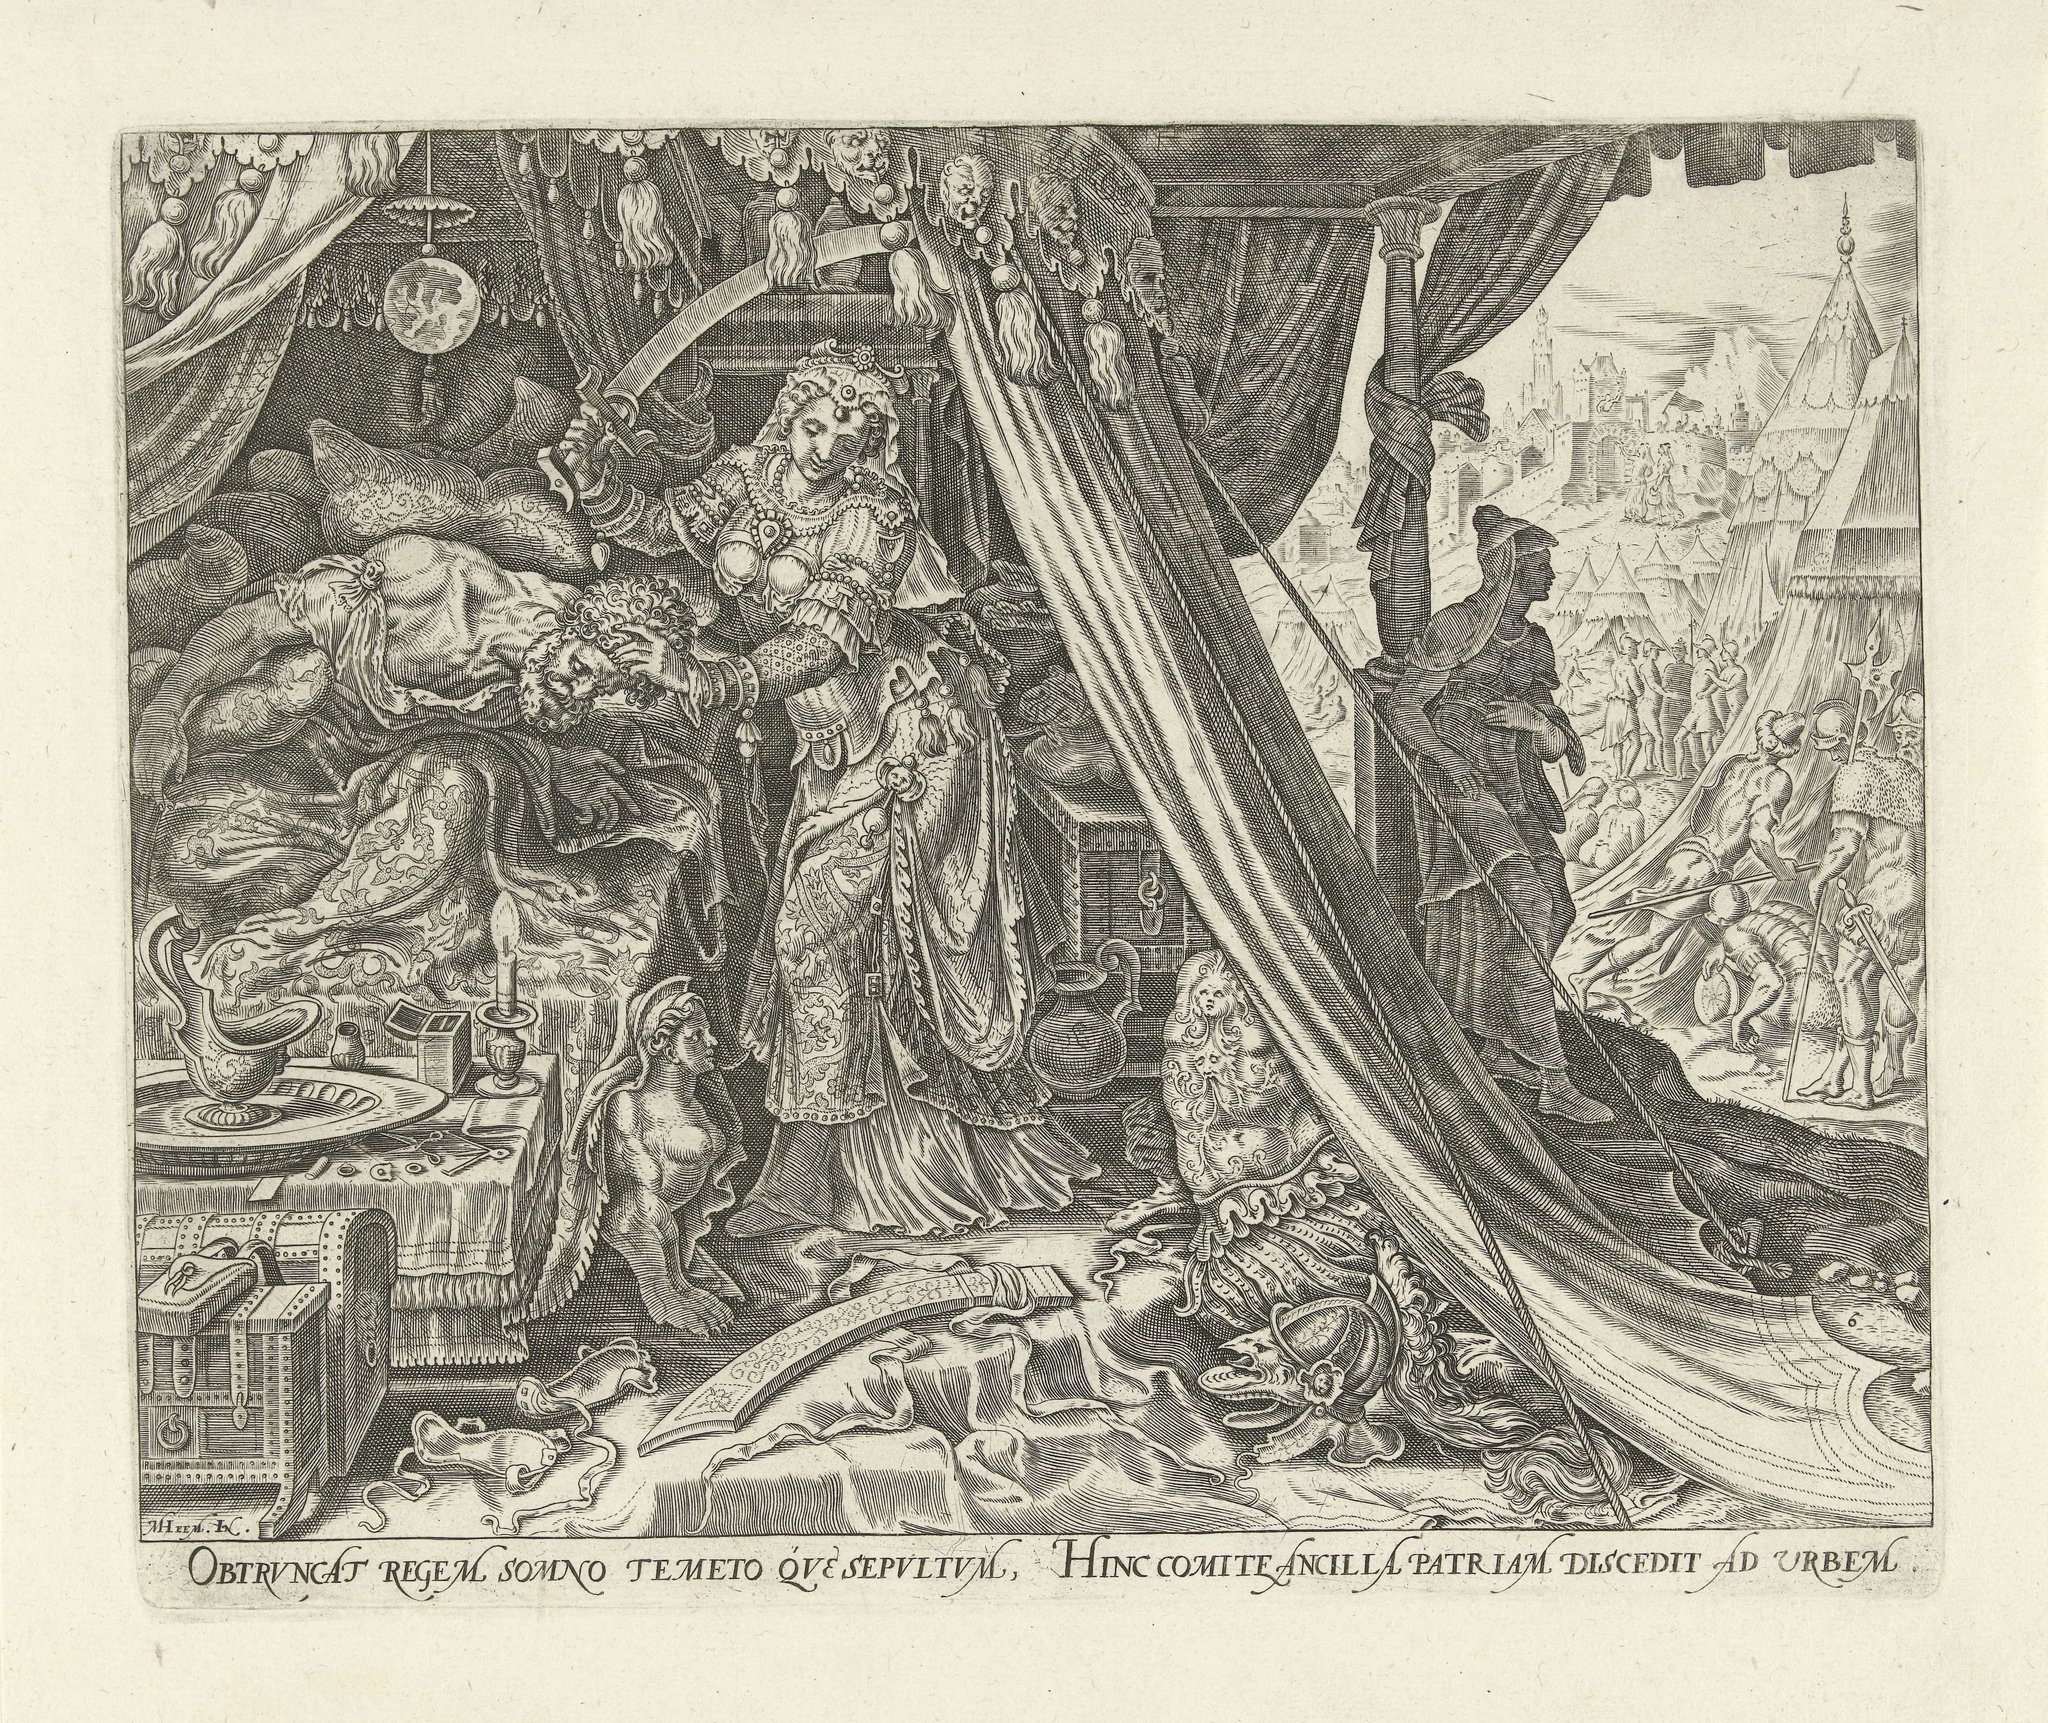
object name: print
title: Judit onthoofdt Holofernes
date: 1564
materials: paper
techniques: engraving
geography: haarlem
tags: holofernes beheaded by judith with his own sword; the maidservant may be keeping watch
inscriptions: collector's mark: Lugt 2228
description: In zijn legertent ligt Holofernes te slapen. Judit grijpt hem met een hand bij zijn hoofd vast, in de andere hand houdt zij een opgeheven kromzwaard. Harnas, helm en andere kledingstukken liggen op de grond. Buiten de tent houdt de dienstmaagd de wacht.